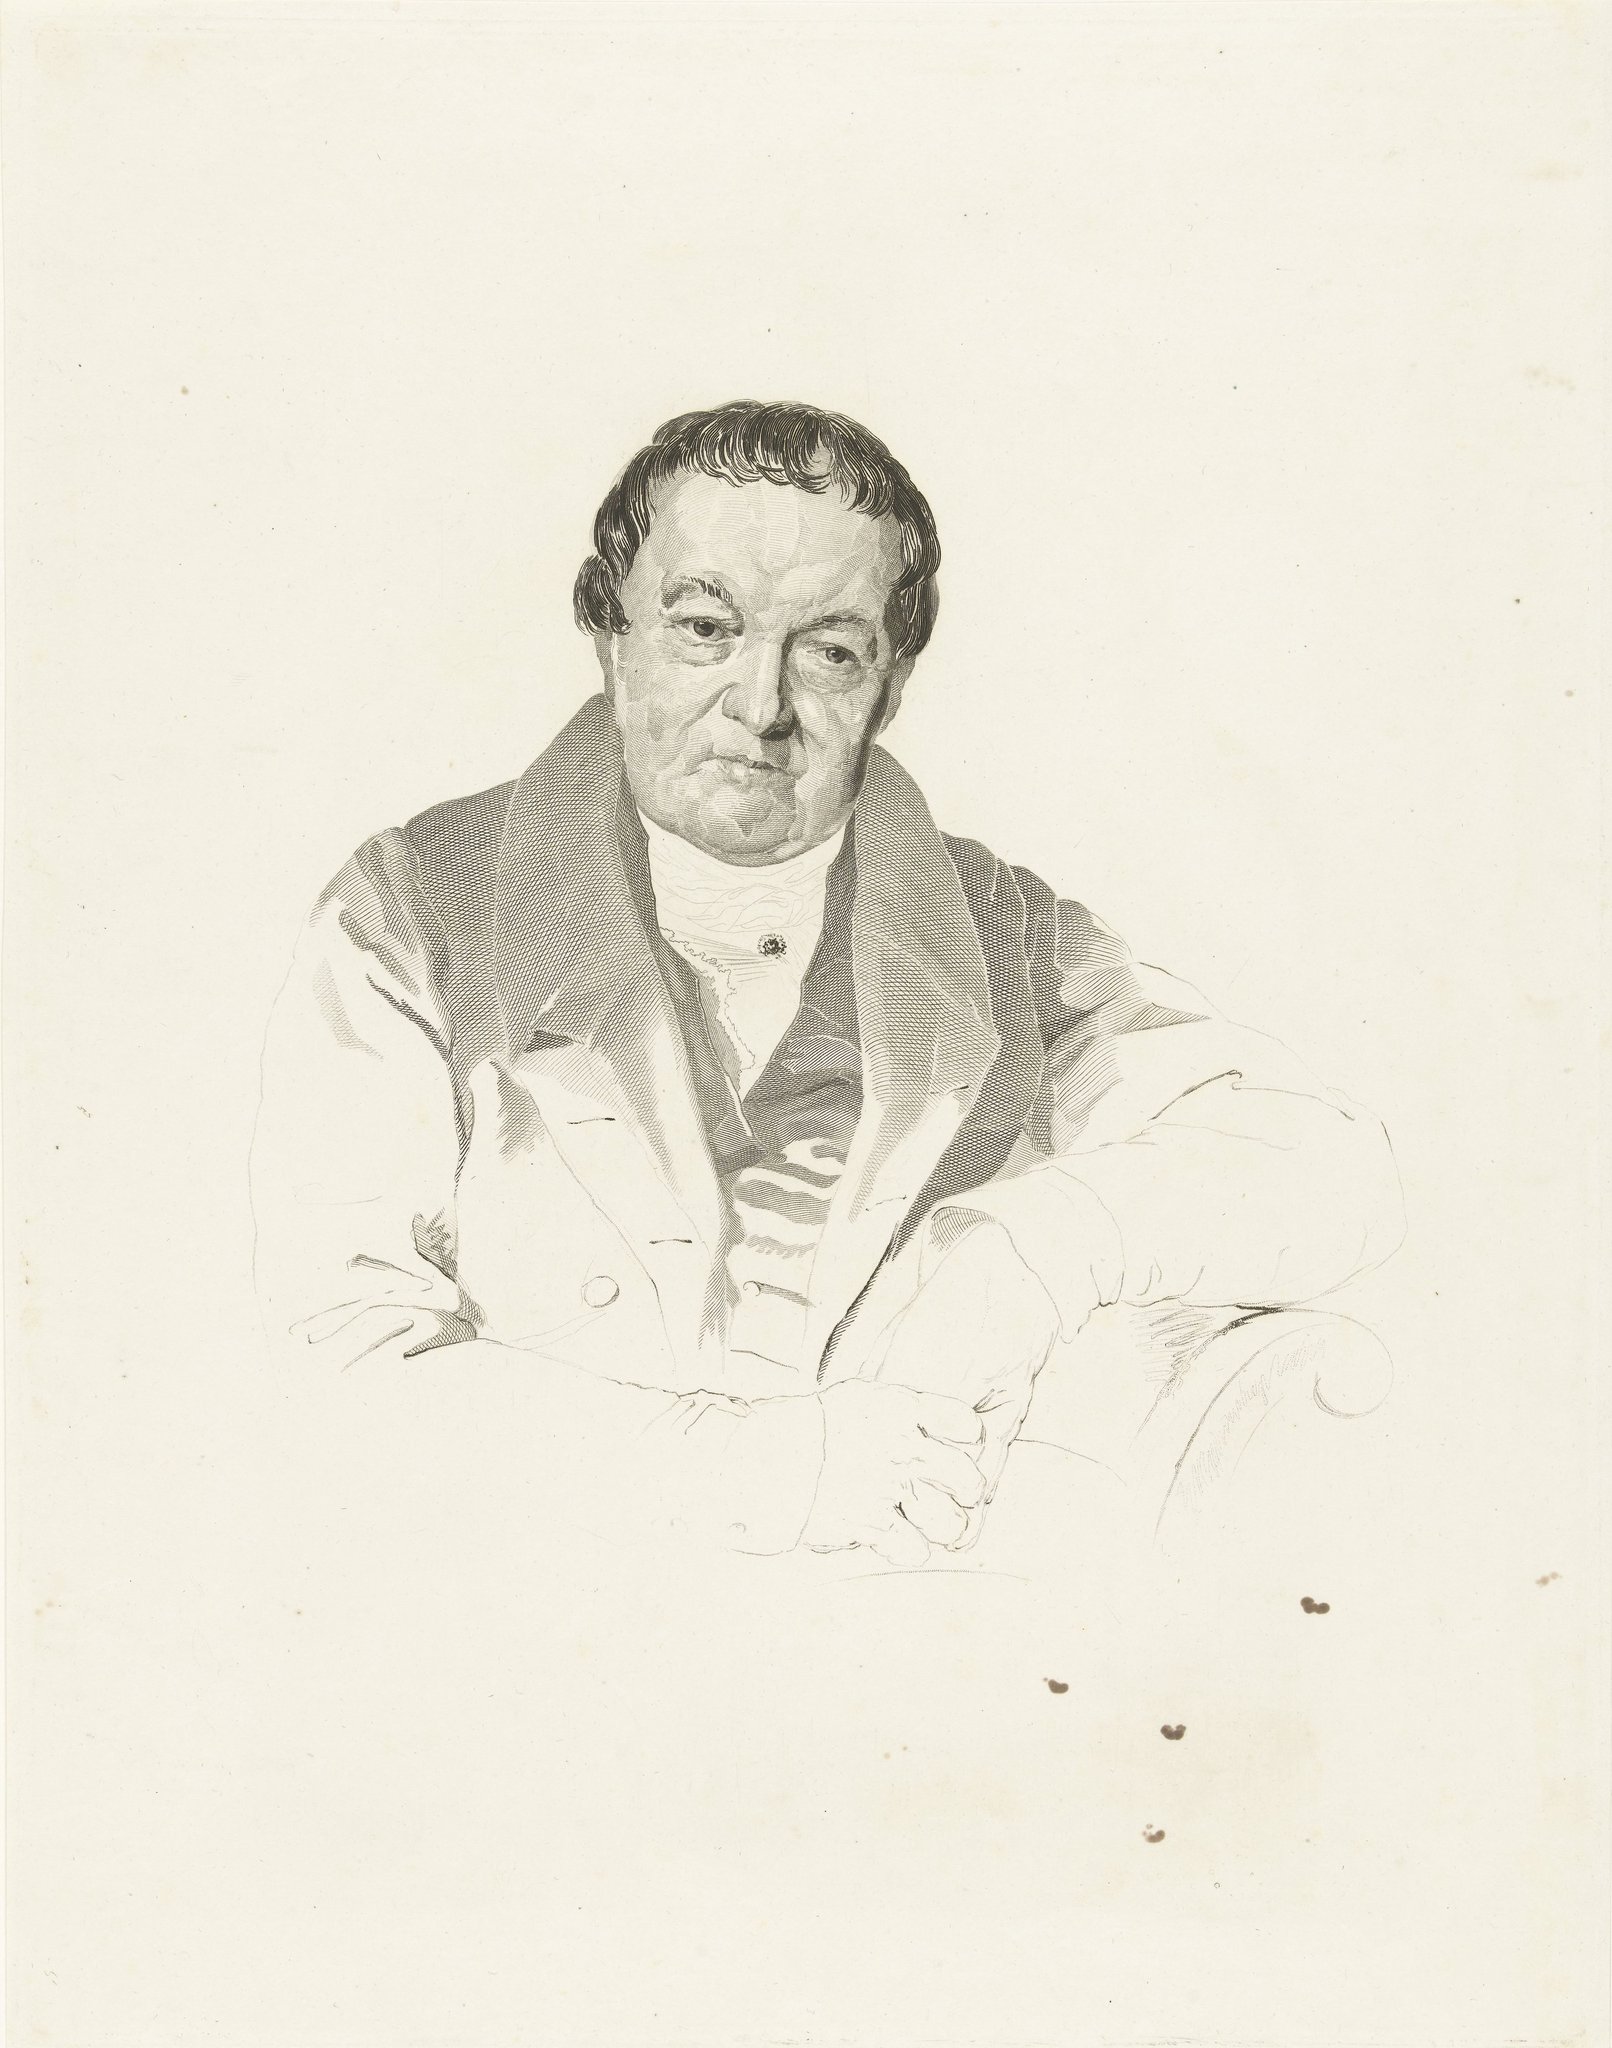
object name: print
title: Portret van de kunstverzamelaar Louis Splitgerber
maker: henricus wilhelmus couwenberg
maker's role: draughtsman, print maker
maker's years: 1814-1845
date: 1838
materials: paper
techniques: engraving, roulette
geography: amsterdam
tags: art collector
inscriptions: collector's mark: Lugt 2228